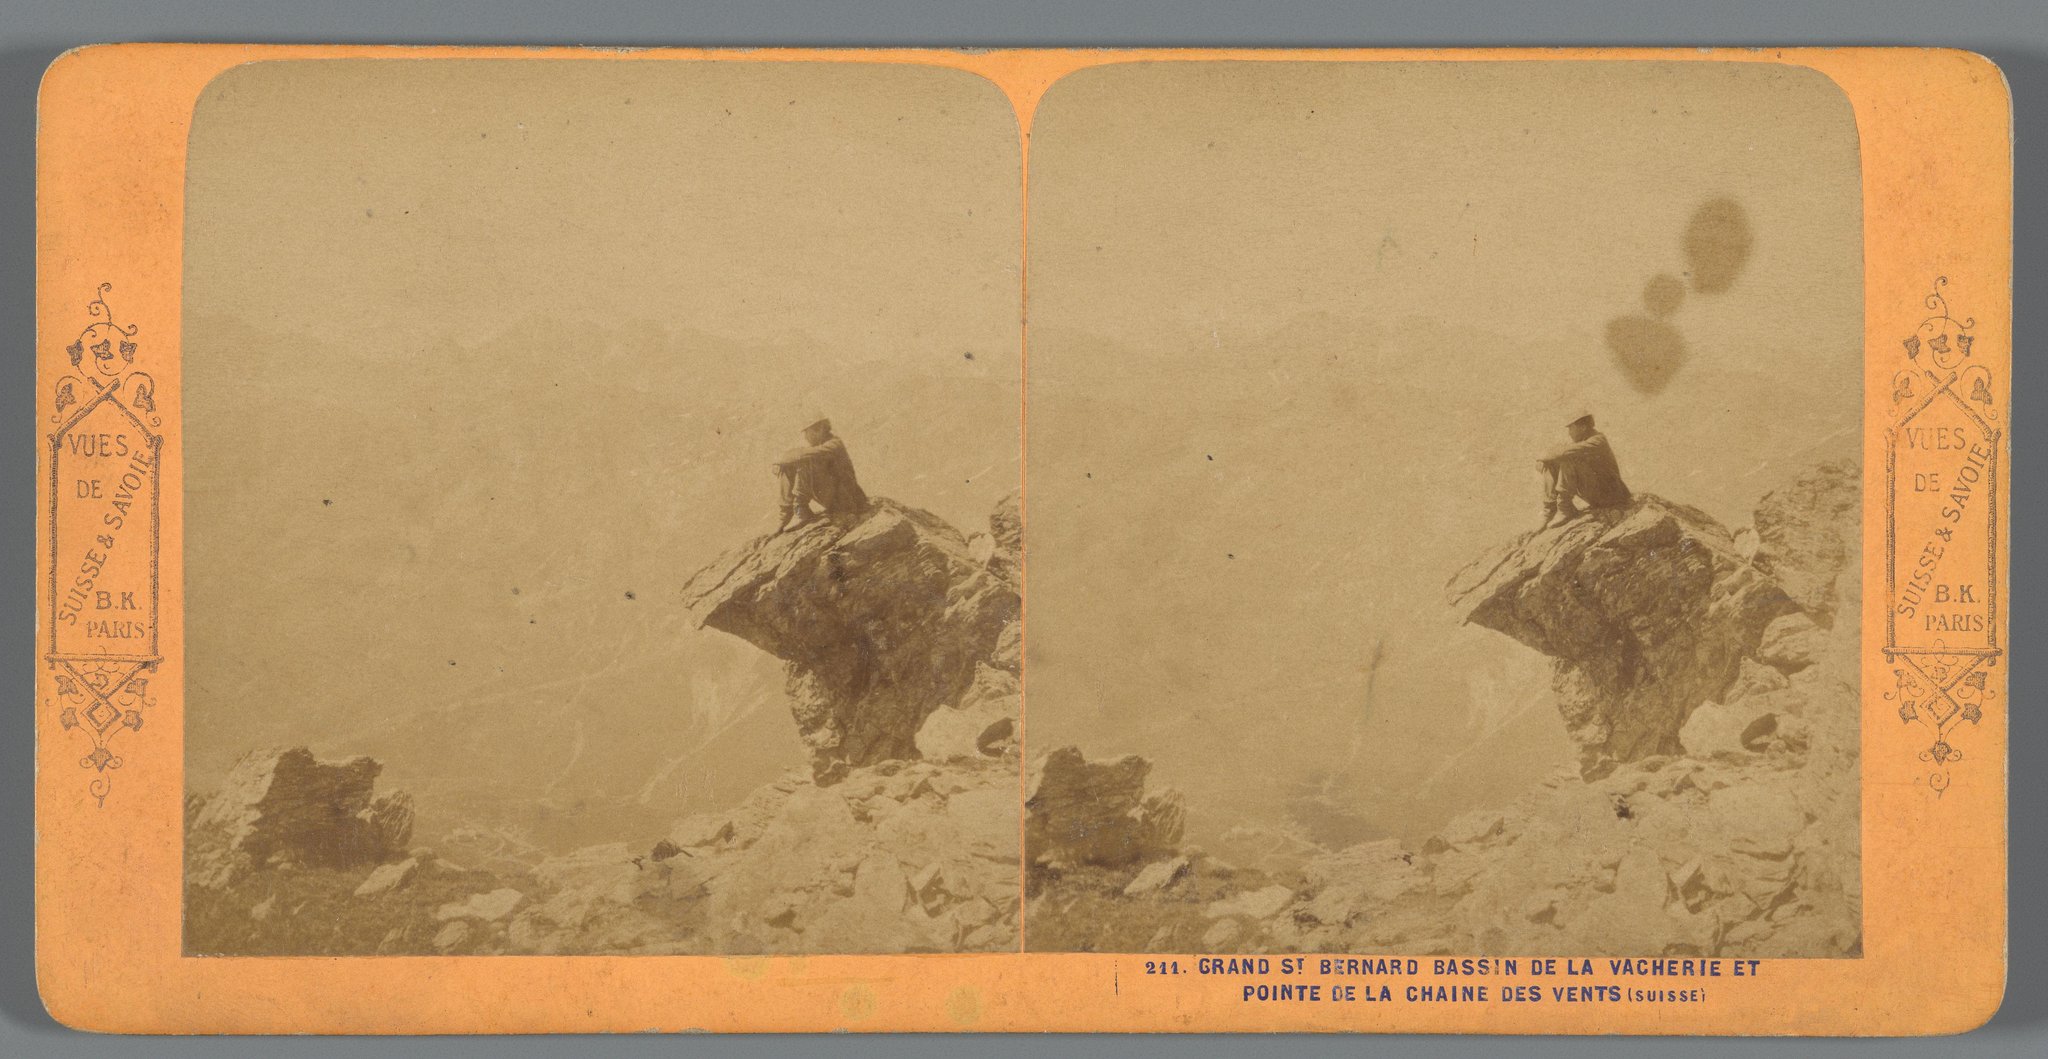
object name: stereograph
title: Vues de Suisse & Savoie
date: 1868-1890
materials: cardboard, paper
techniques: albumen print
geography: paris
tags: mountains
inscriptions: number: ‘211.’